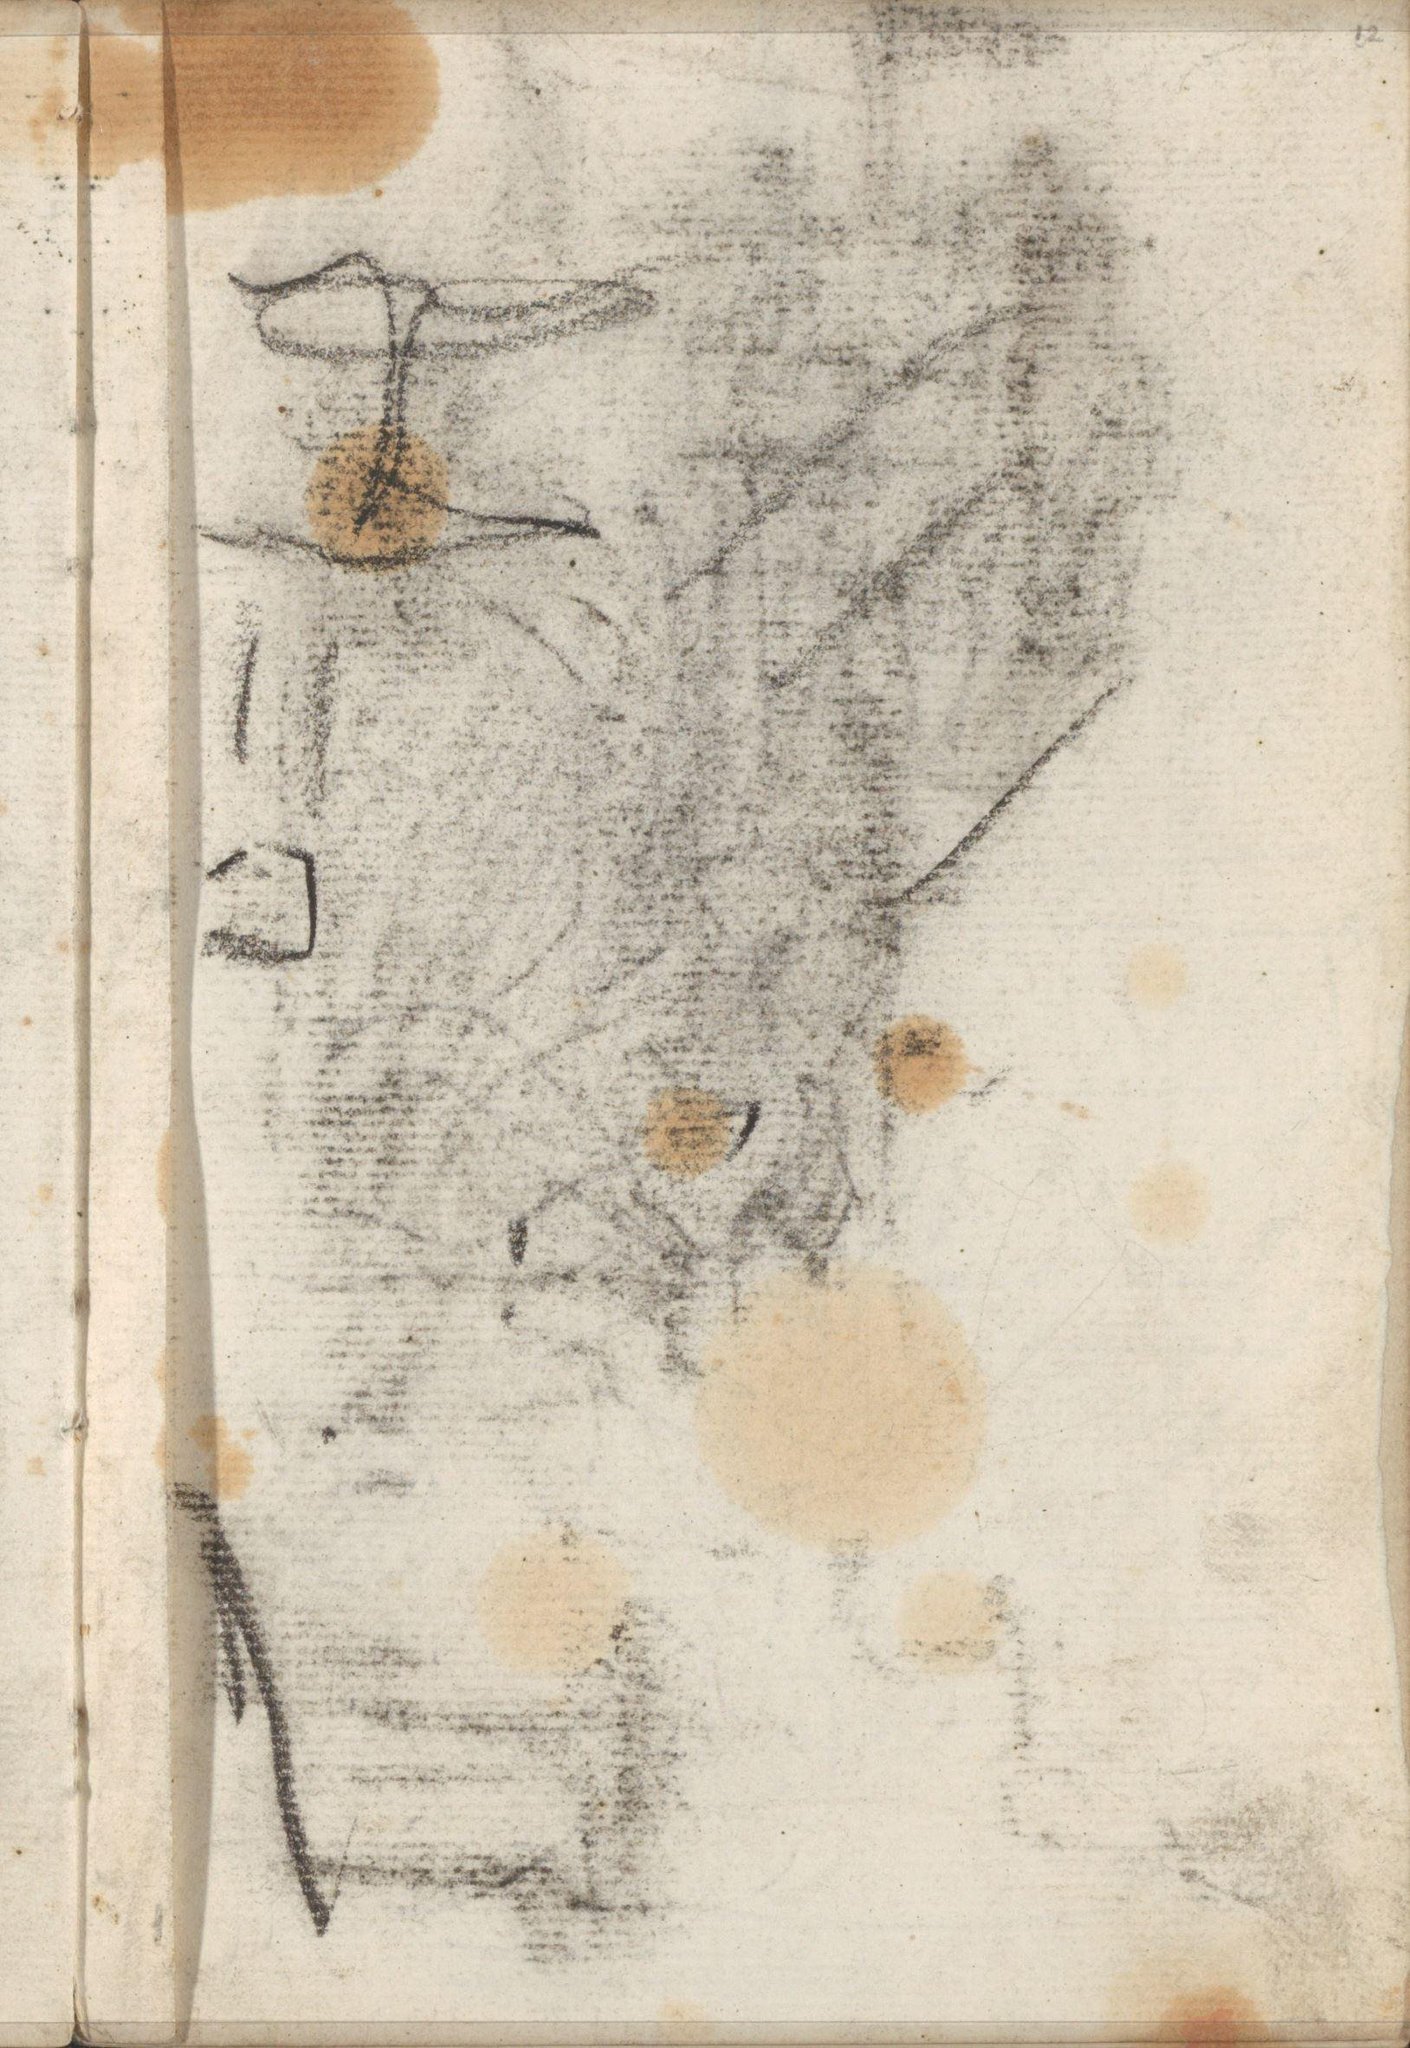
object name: sketchbook leaf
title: Studie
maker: george hendrik breitner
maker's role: draughtsman, painter, print maker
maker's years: 1857-1923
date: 1895-1898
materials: chalk, paper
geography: amsterdam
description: Pagina 12 uit een schetsboek met 20 bladen.